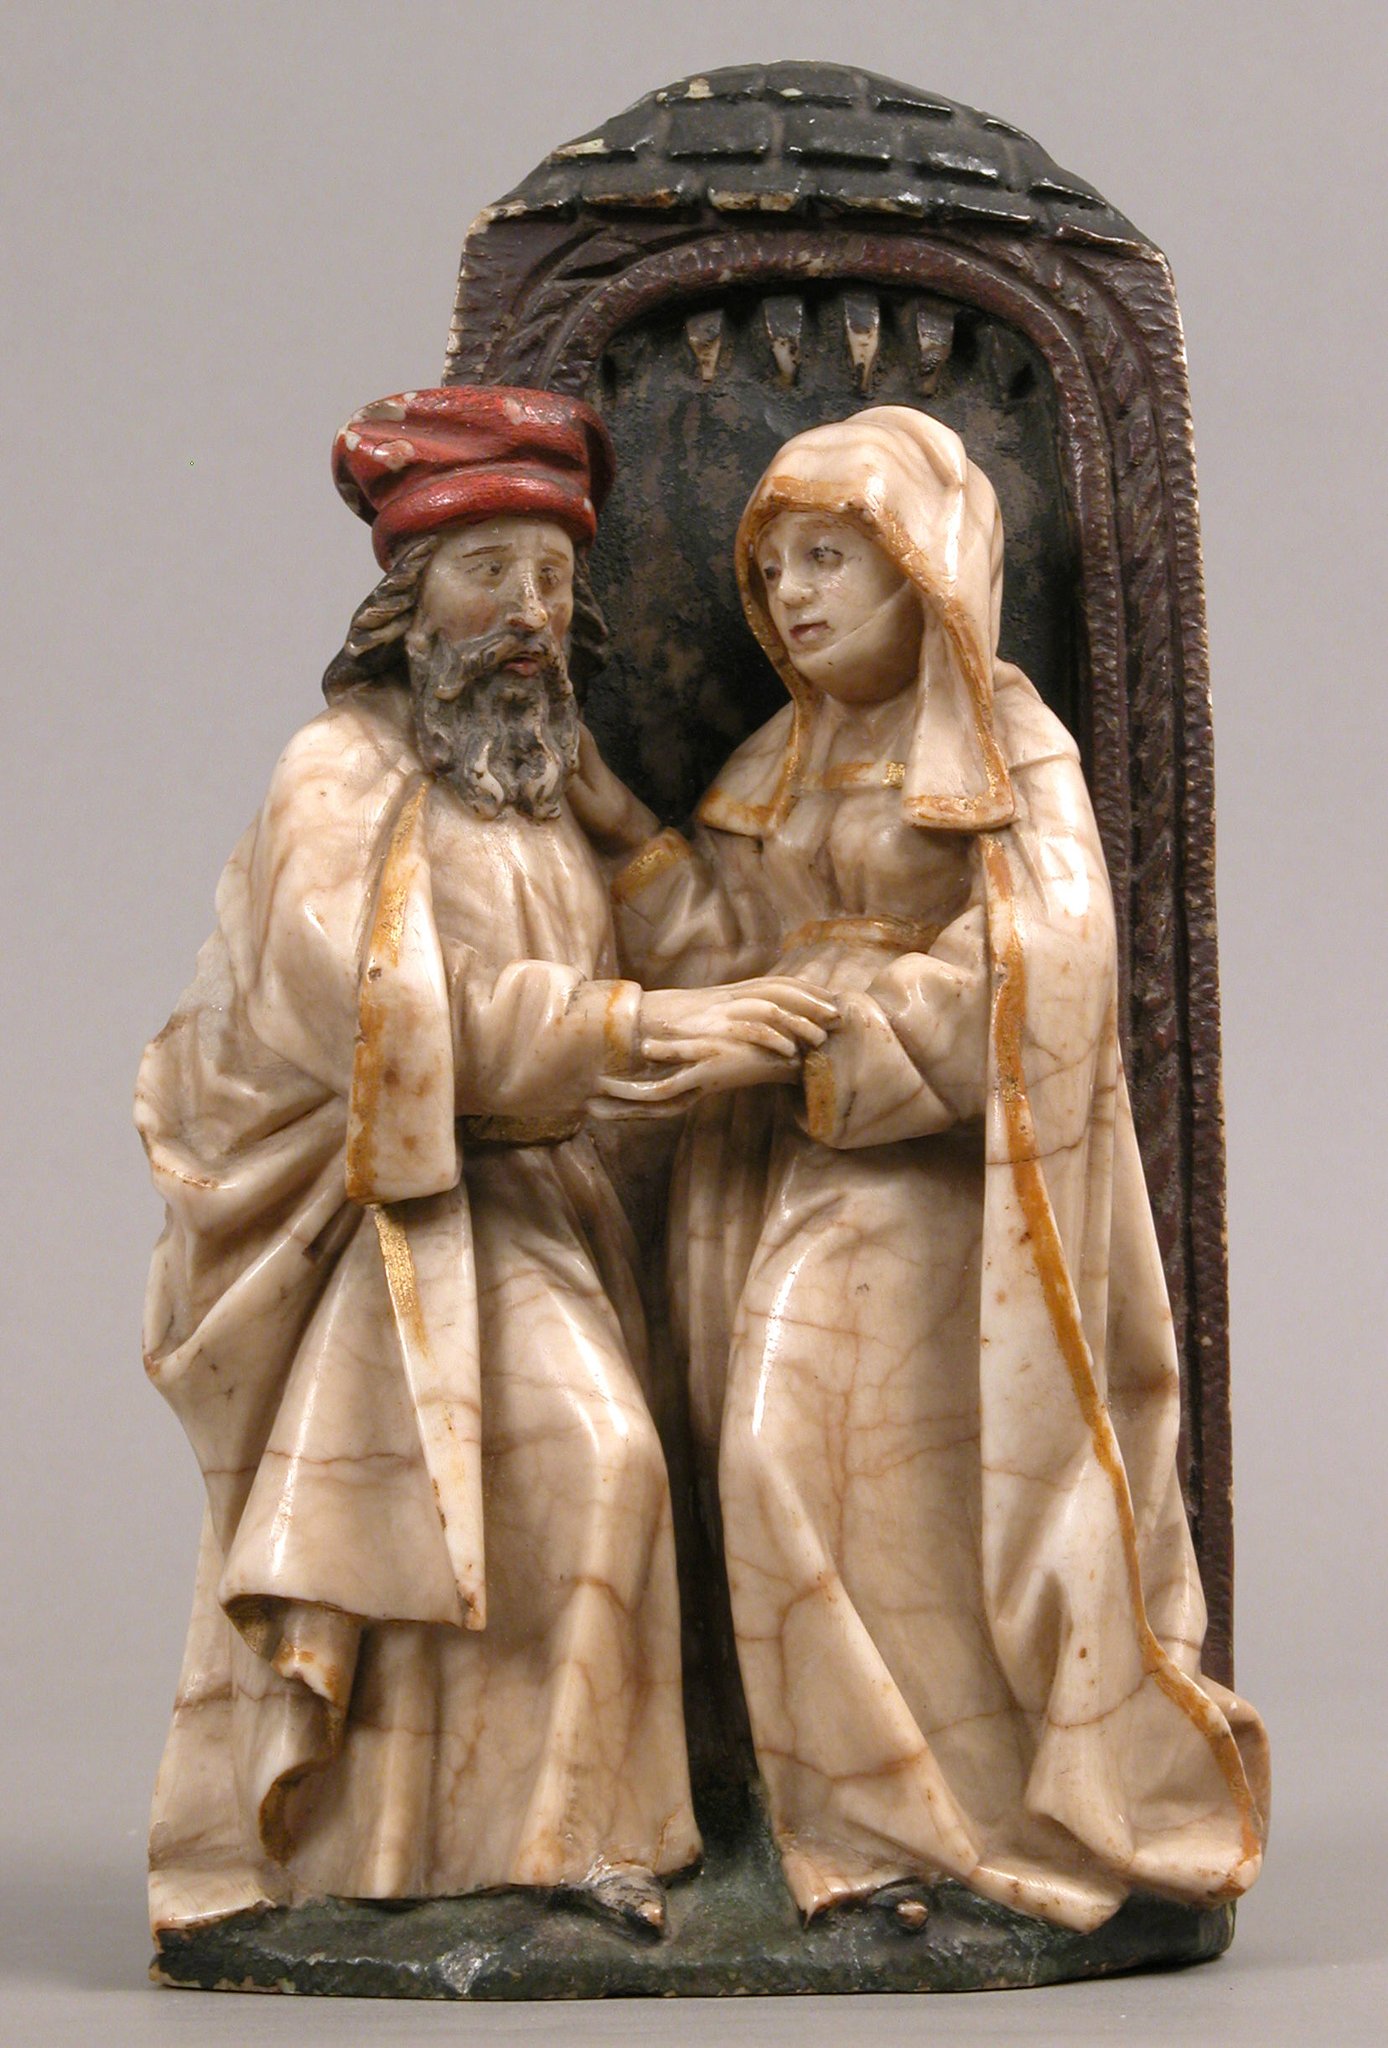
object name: wall group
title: Saint Anna and Saint Joachim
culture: german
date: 1430-1450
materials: alabaster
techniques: polychromy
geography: germany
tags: saints